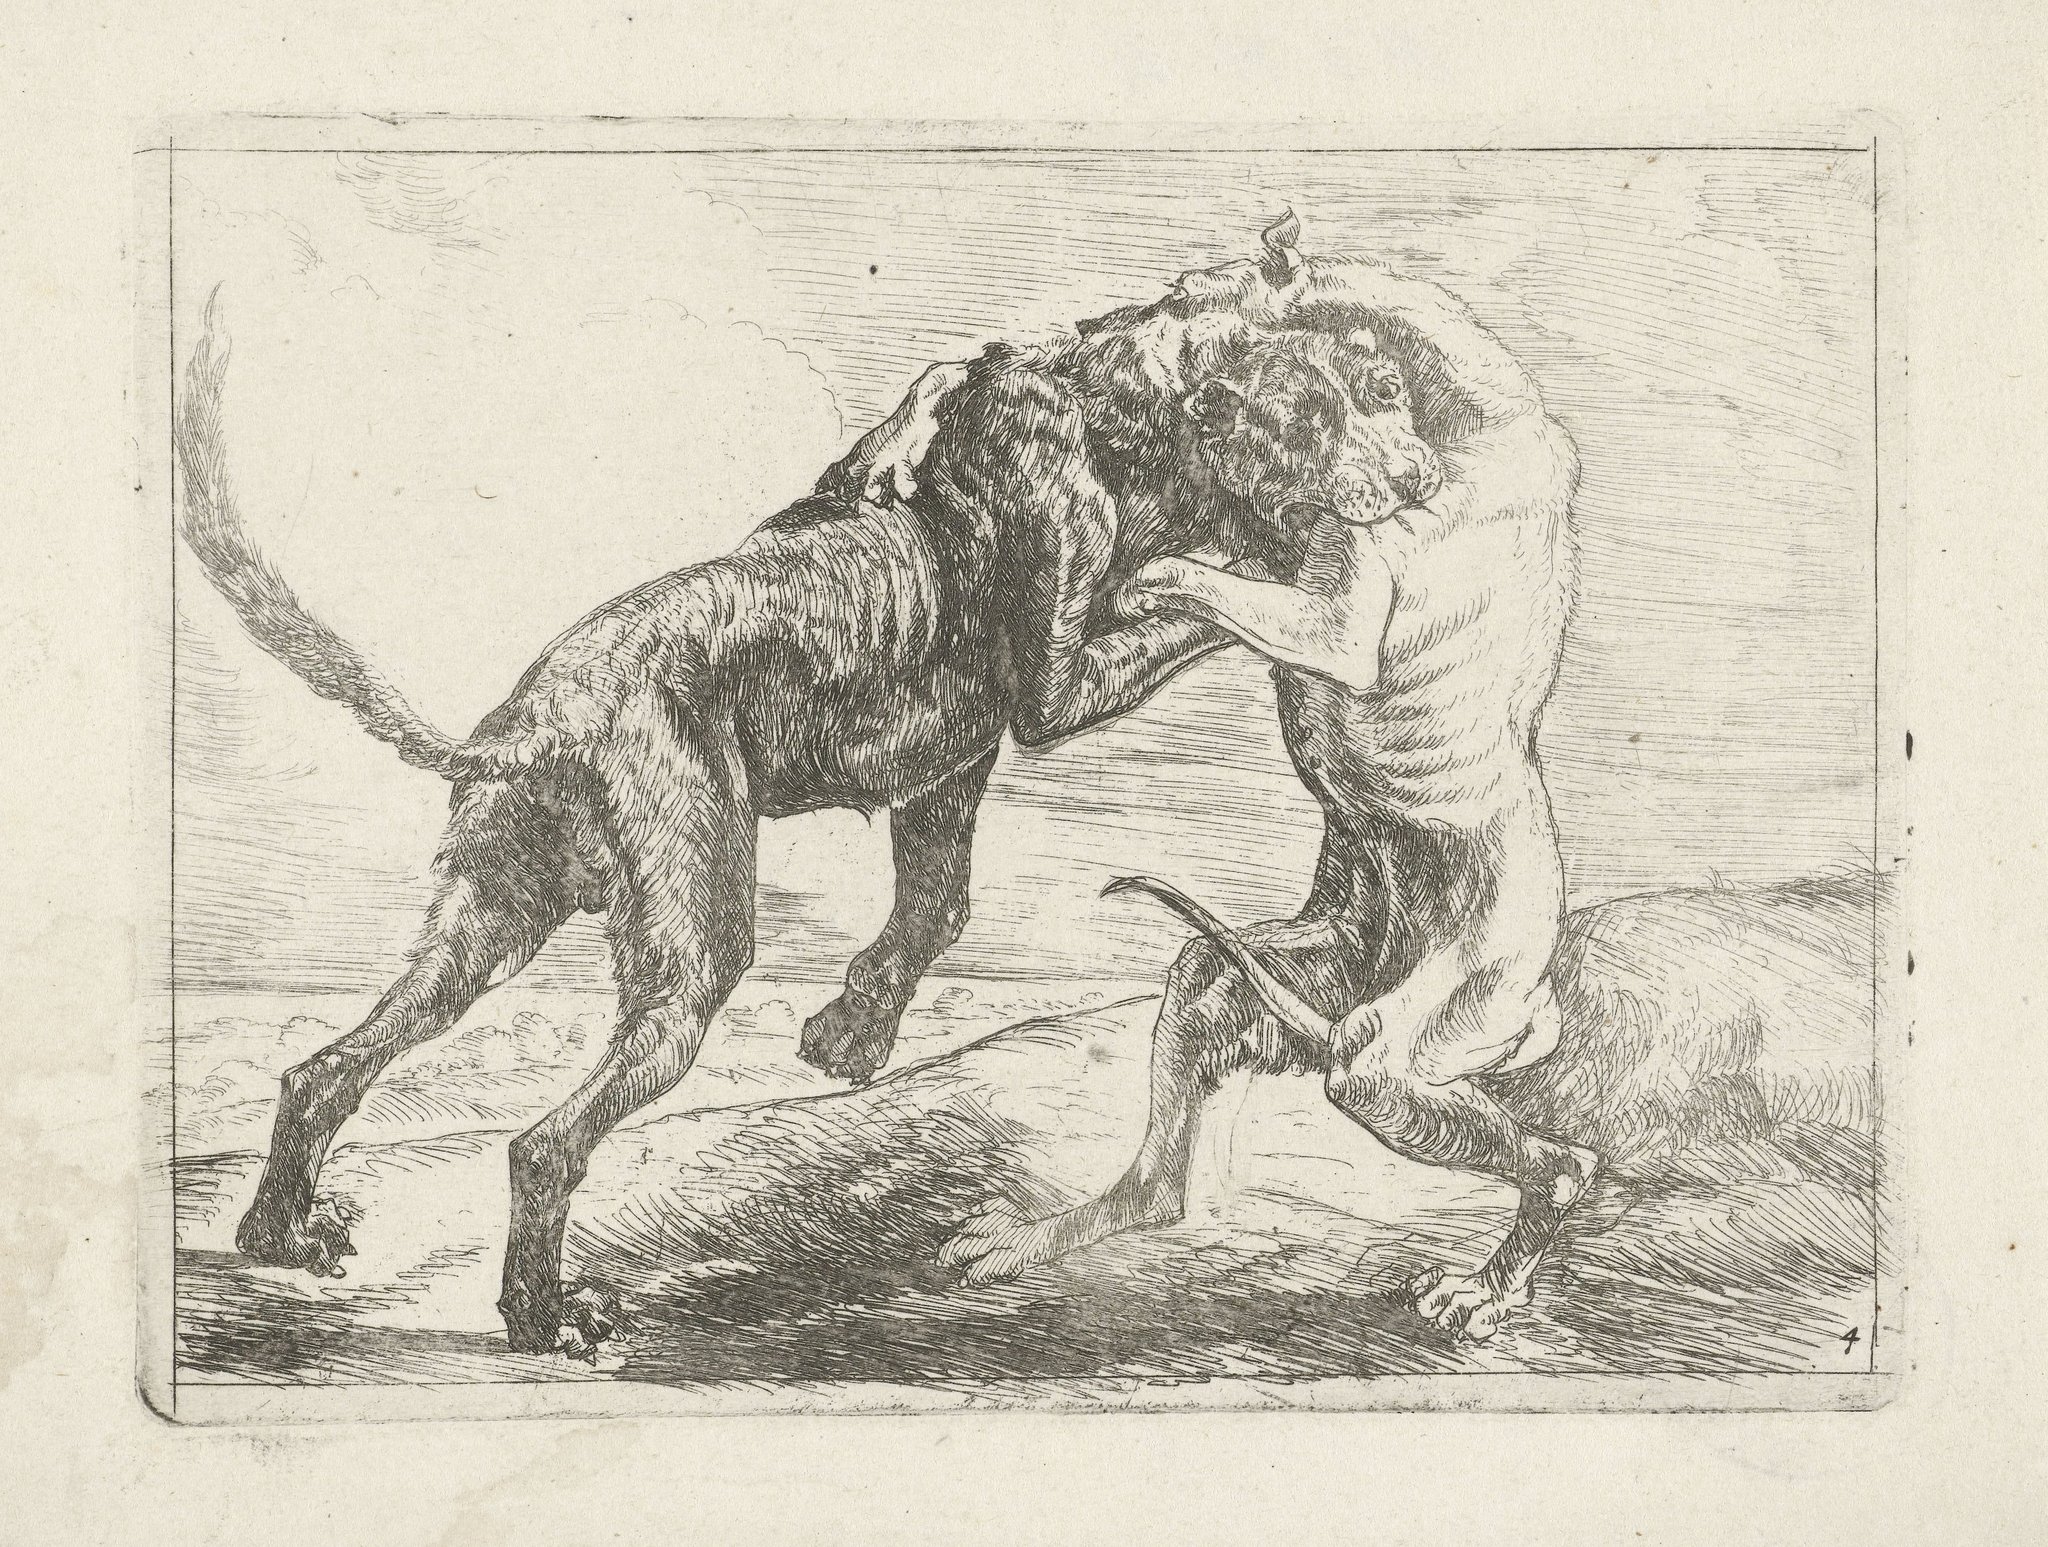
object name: print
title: Twee vechtende honden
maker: pauwels van hillegaert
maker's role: painter, print maker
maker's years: 1596-1658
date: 1654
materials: paper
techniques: etching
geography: amsterdam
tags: dog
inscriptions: collector's mark: Lugt 240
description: Twee vechtende honden in een landschap. Vierde prent van een serie van acht prenten met voorstellingen van honden.